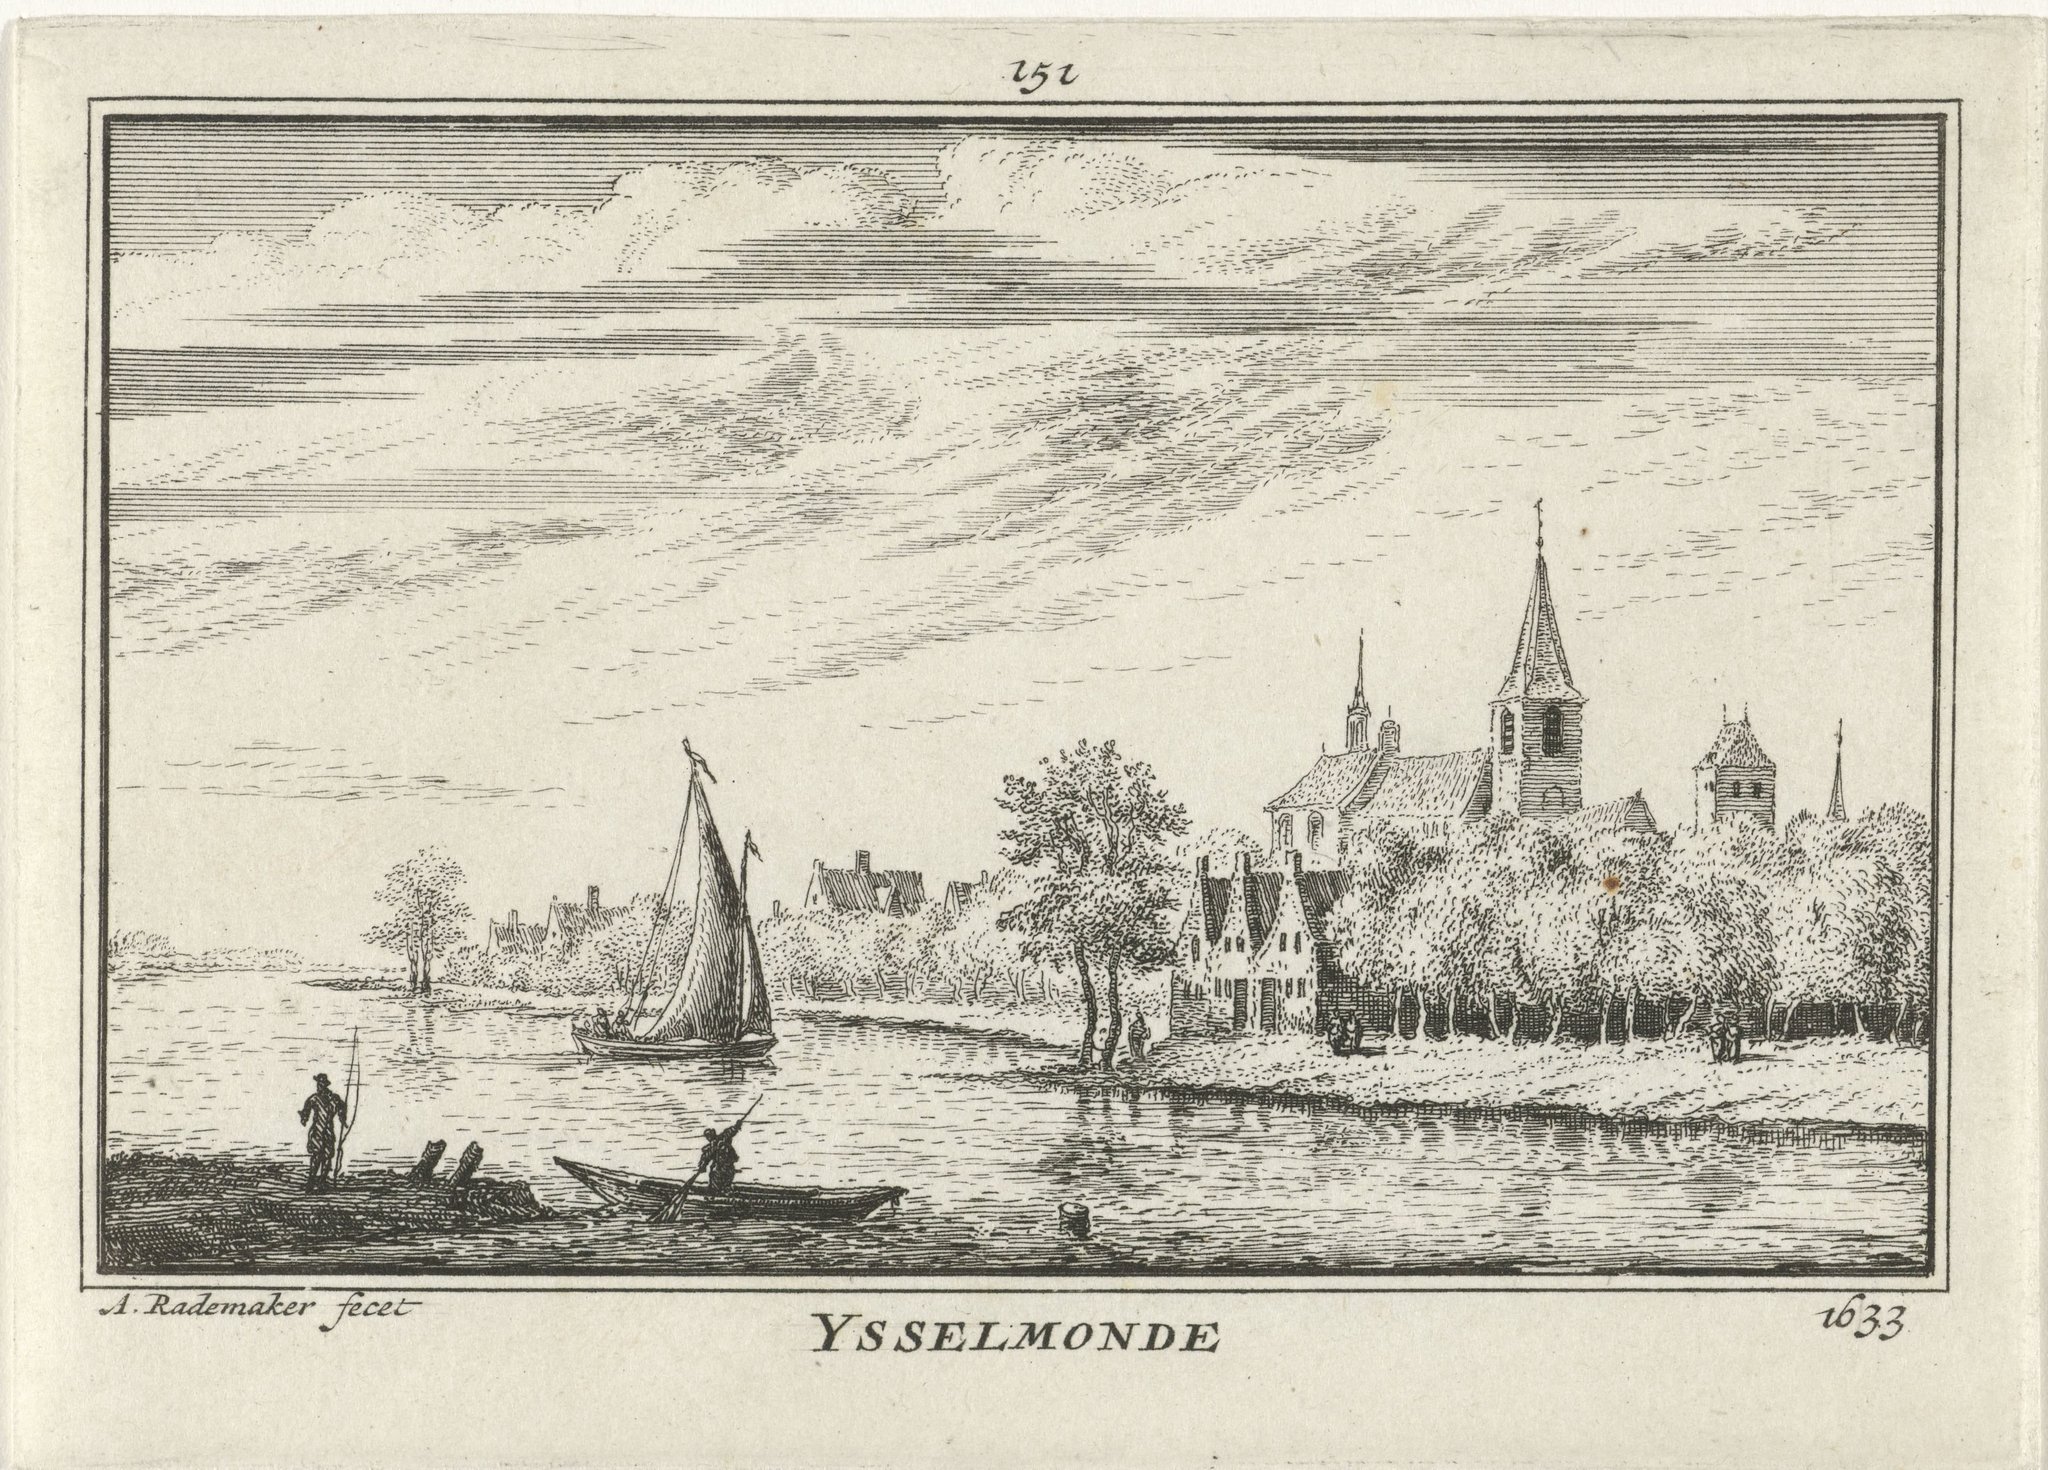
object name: print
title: Ysselmonde 1633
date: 1727-1733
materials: paper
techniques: etching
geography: amsterdam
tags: prospect of village, silhouette of village, sailing-ship, sailing-boat, church (exterior), rowing-boat, canoe, etc., fisherman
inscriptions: collector's mark: Lugt 2228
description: Illustratie uit: Abraham Rademaker, Matthaeus Brouërius van Niedek, Isaac Le Long, Kabinet van Nederlandsche en Kleefsche outheden en (...) voorname stads- en landgebouwen, Willem Barents en Antoni Schoonenburg: Amsterdam, 1727-1733, ill. nr. 151.